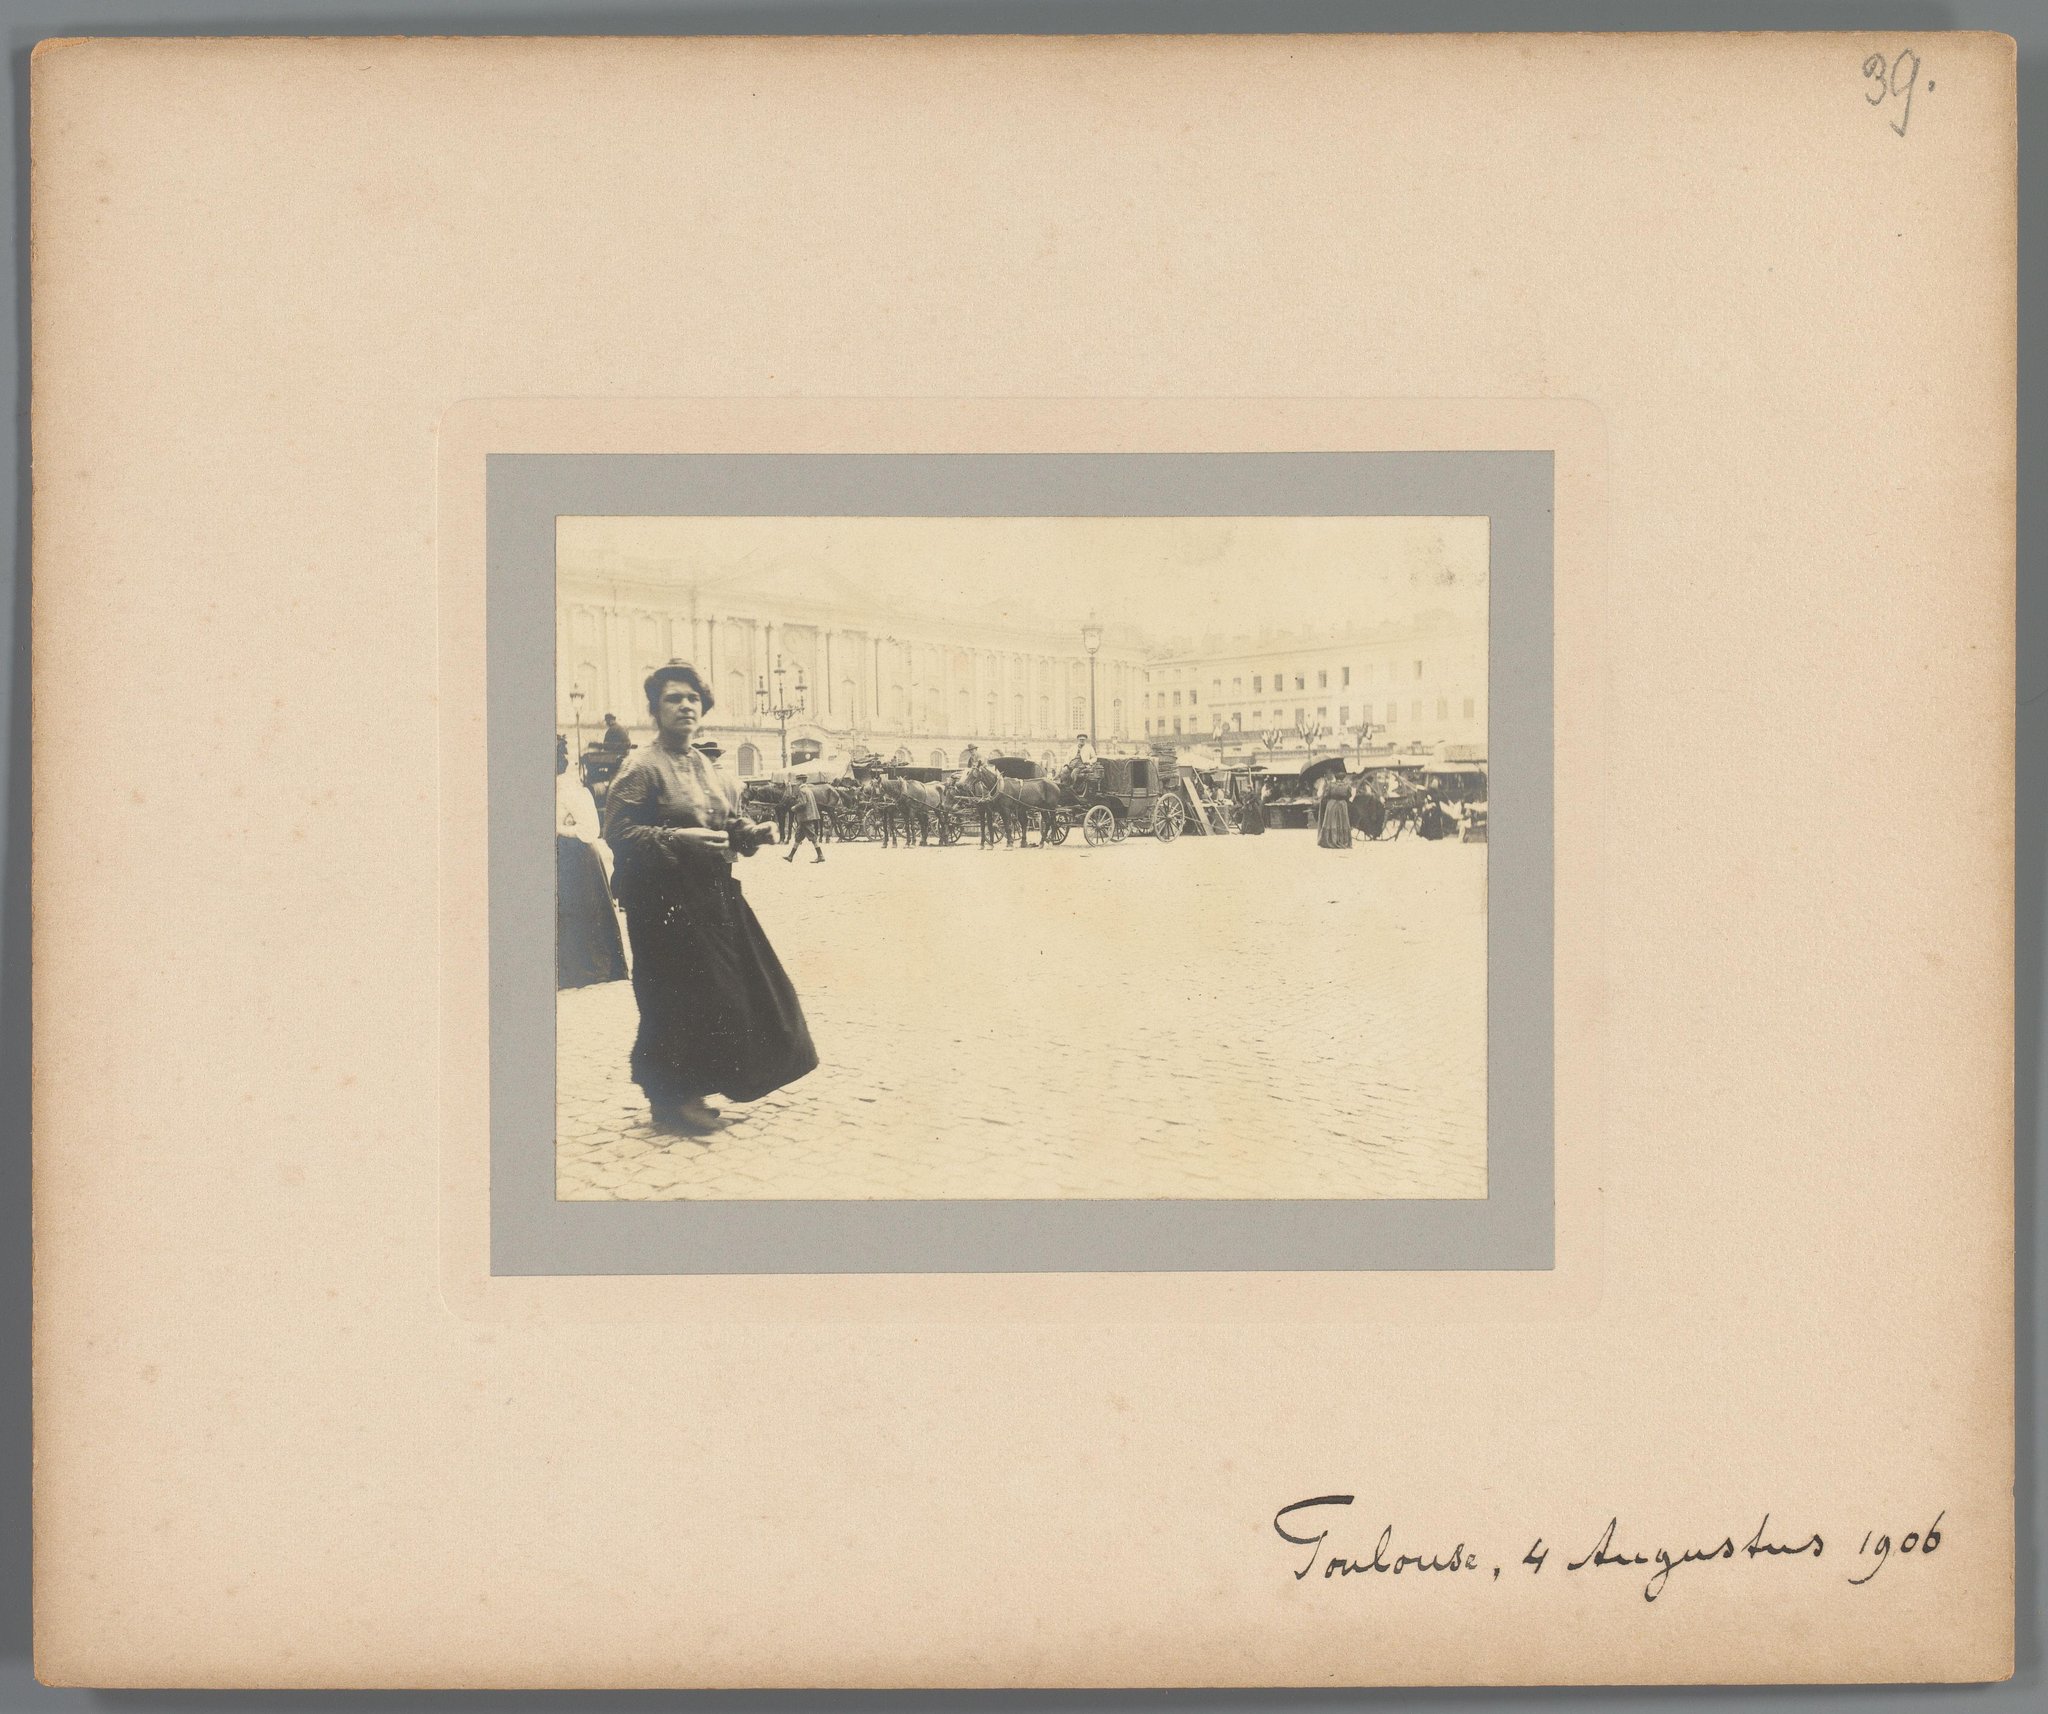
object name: photograph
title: Vrouw op een plein met rijtuigen, Toulouse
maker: françois buys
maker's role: advocaat, amateurfotograaf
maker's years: 1871-1934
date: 1906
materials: paper, cardboard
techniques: gelatin silver print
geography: toulouse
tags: square, place, circus, etc.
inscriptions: number: ‘39’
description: Deze foto maakt deel uit van een groep van 49 foto's.